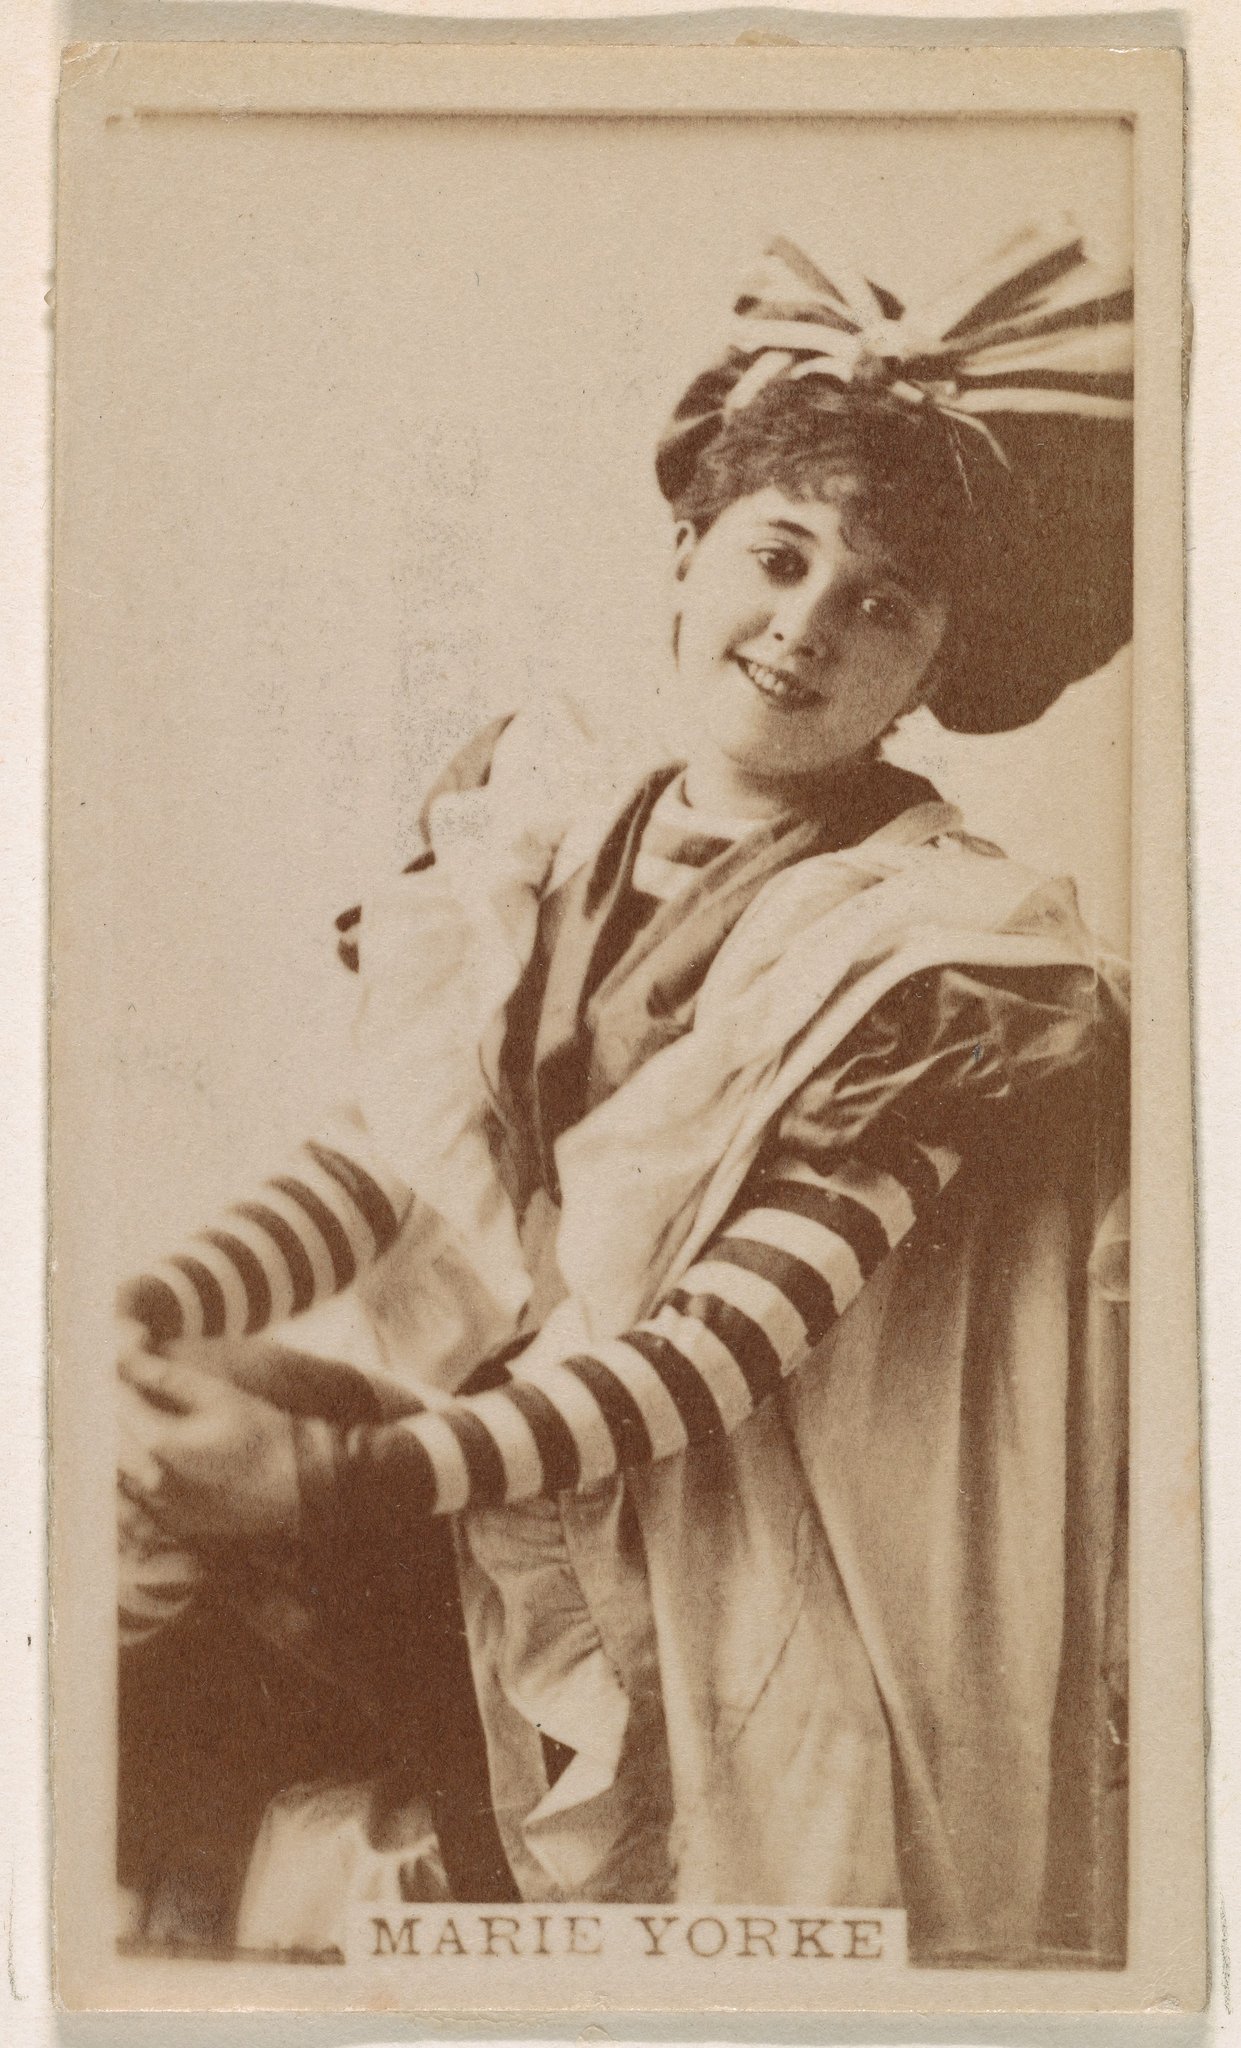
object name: photograph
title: Marie Yorke, from the Actresses series (N245) issued by Kinney Brothers to promote Sweet Caporal Cigarettes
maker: kinney brothers tobacco company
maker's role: publisher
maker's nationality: american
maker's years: 1869-2011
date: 1890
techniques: albumen silver print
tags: portraits,women,actresses